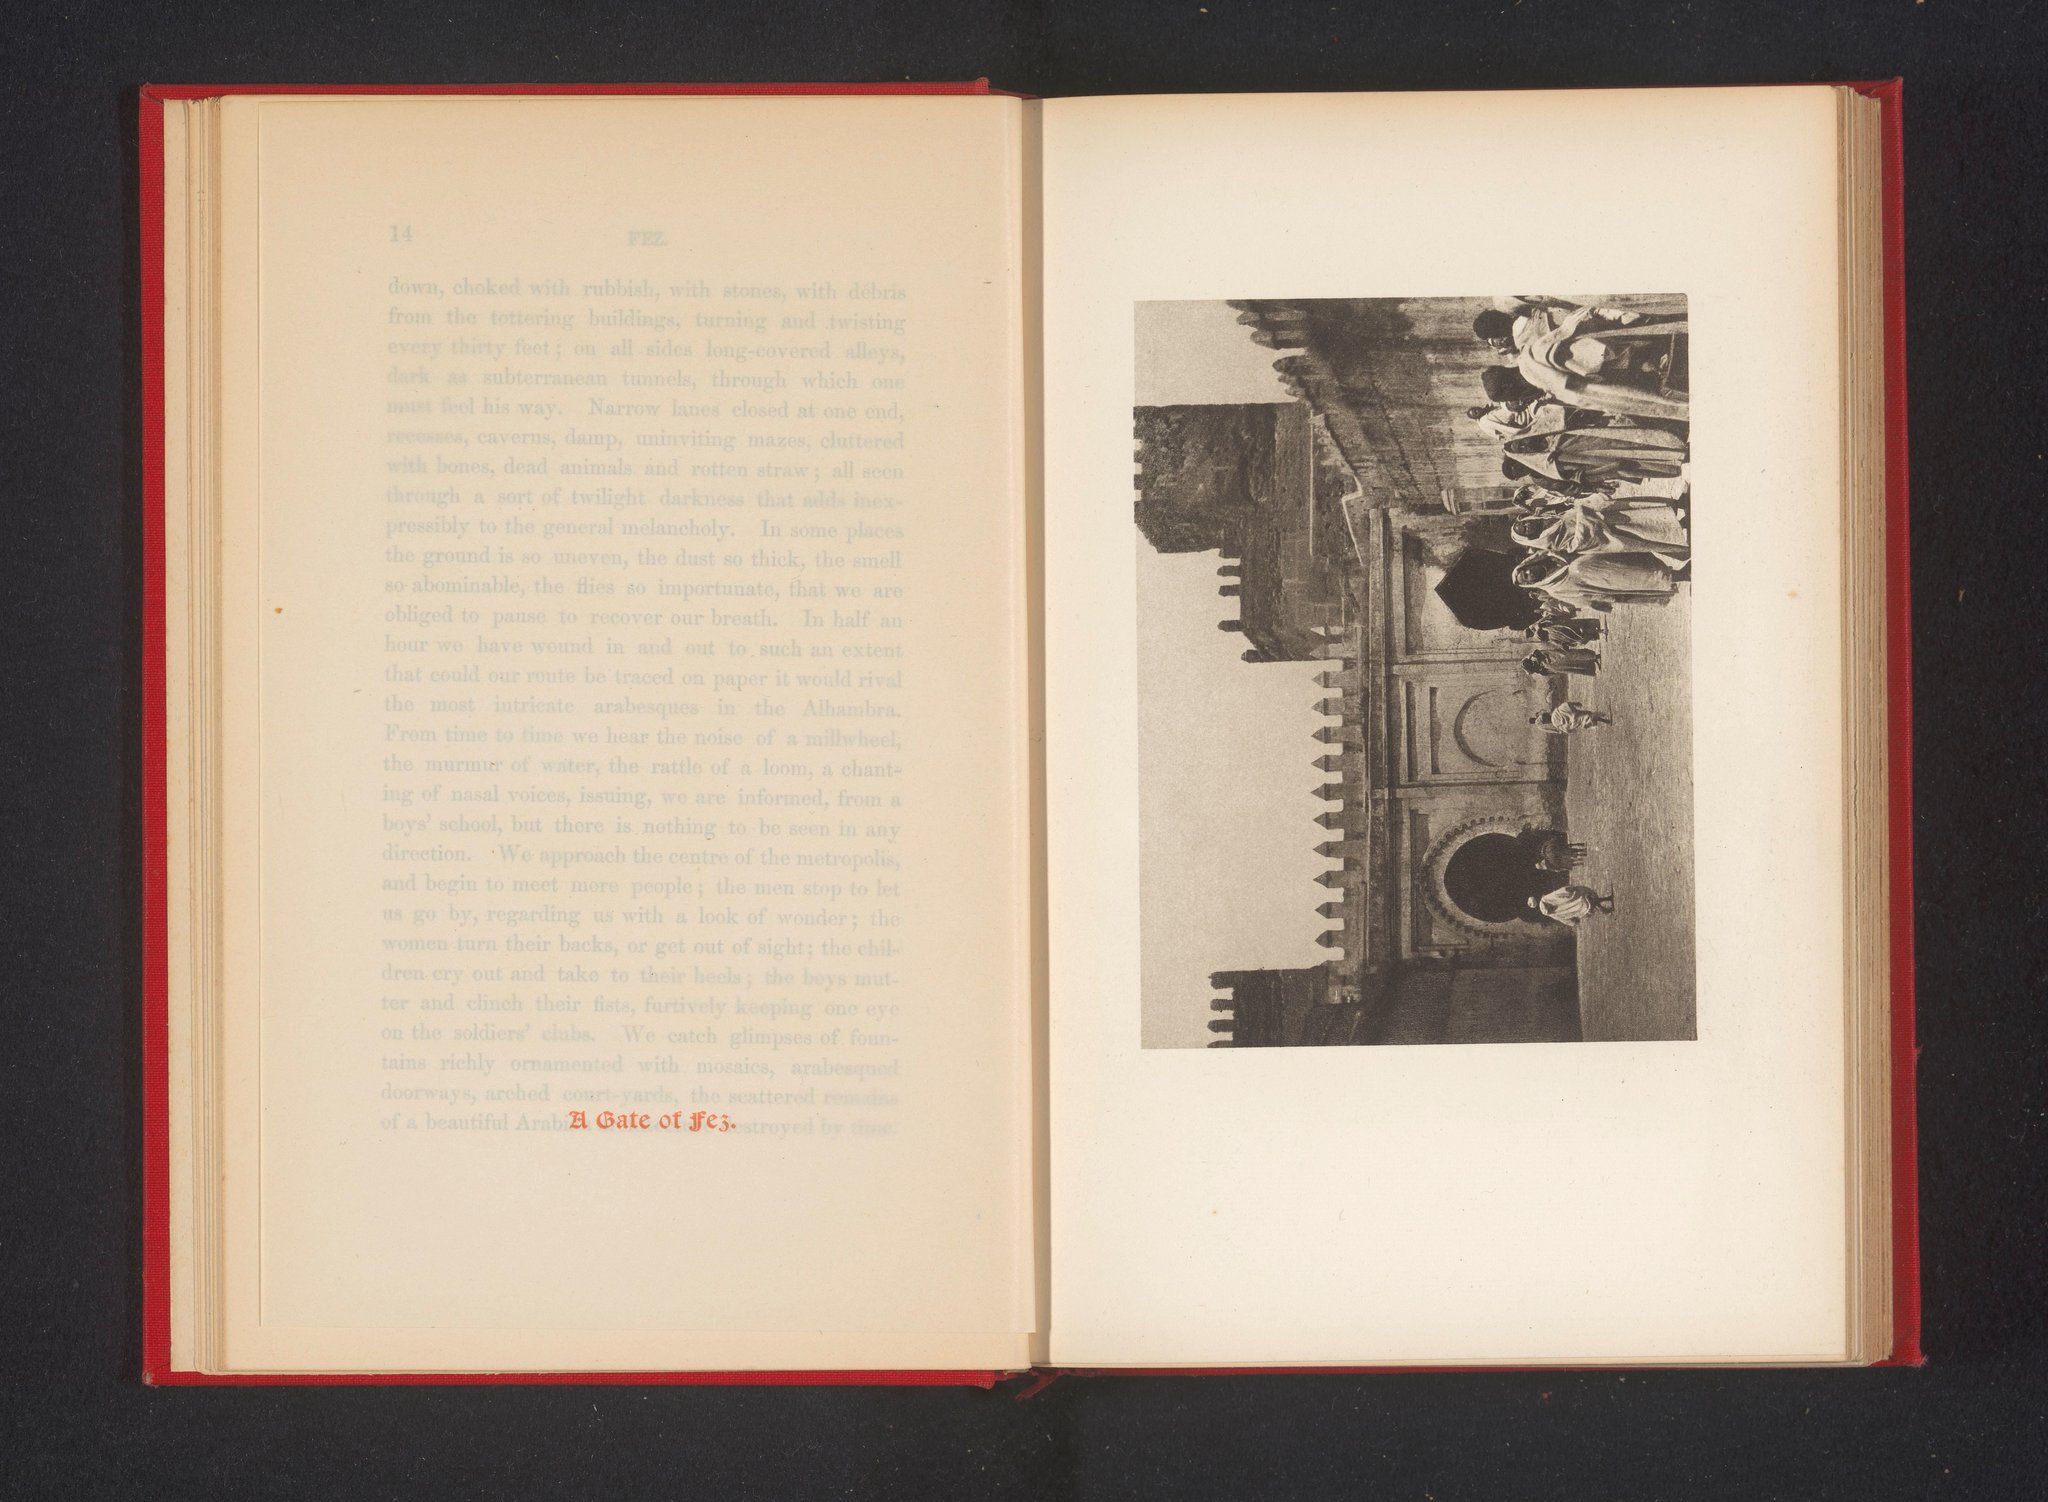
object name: page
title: Gezicht op een stadspoort te Fez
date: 1887-1897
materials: paper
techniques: photoaquatint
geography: fez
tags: city-gate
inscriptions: title: ‘A Gate of Fez.’